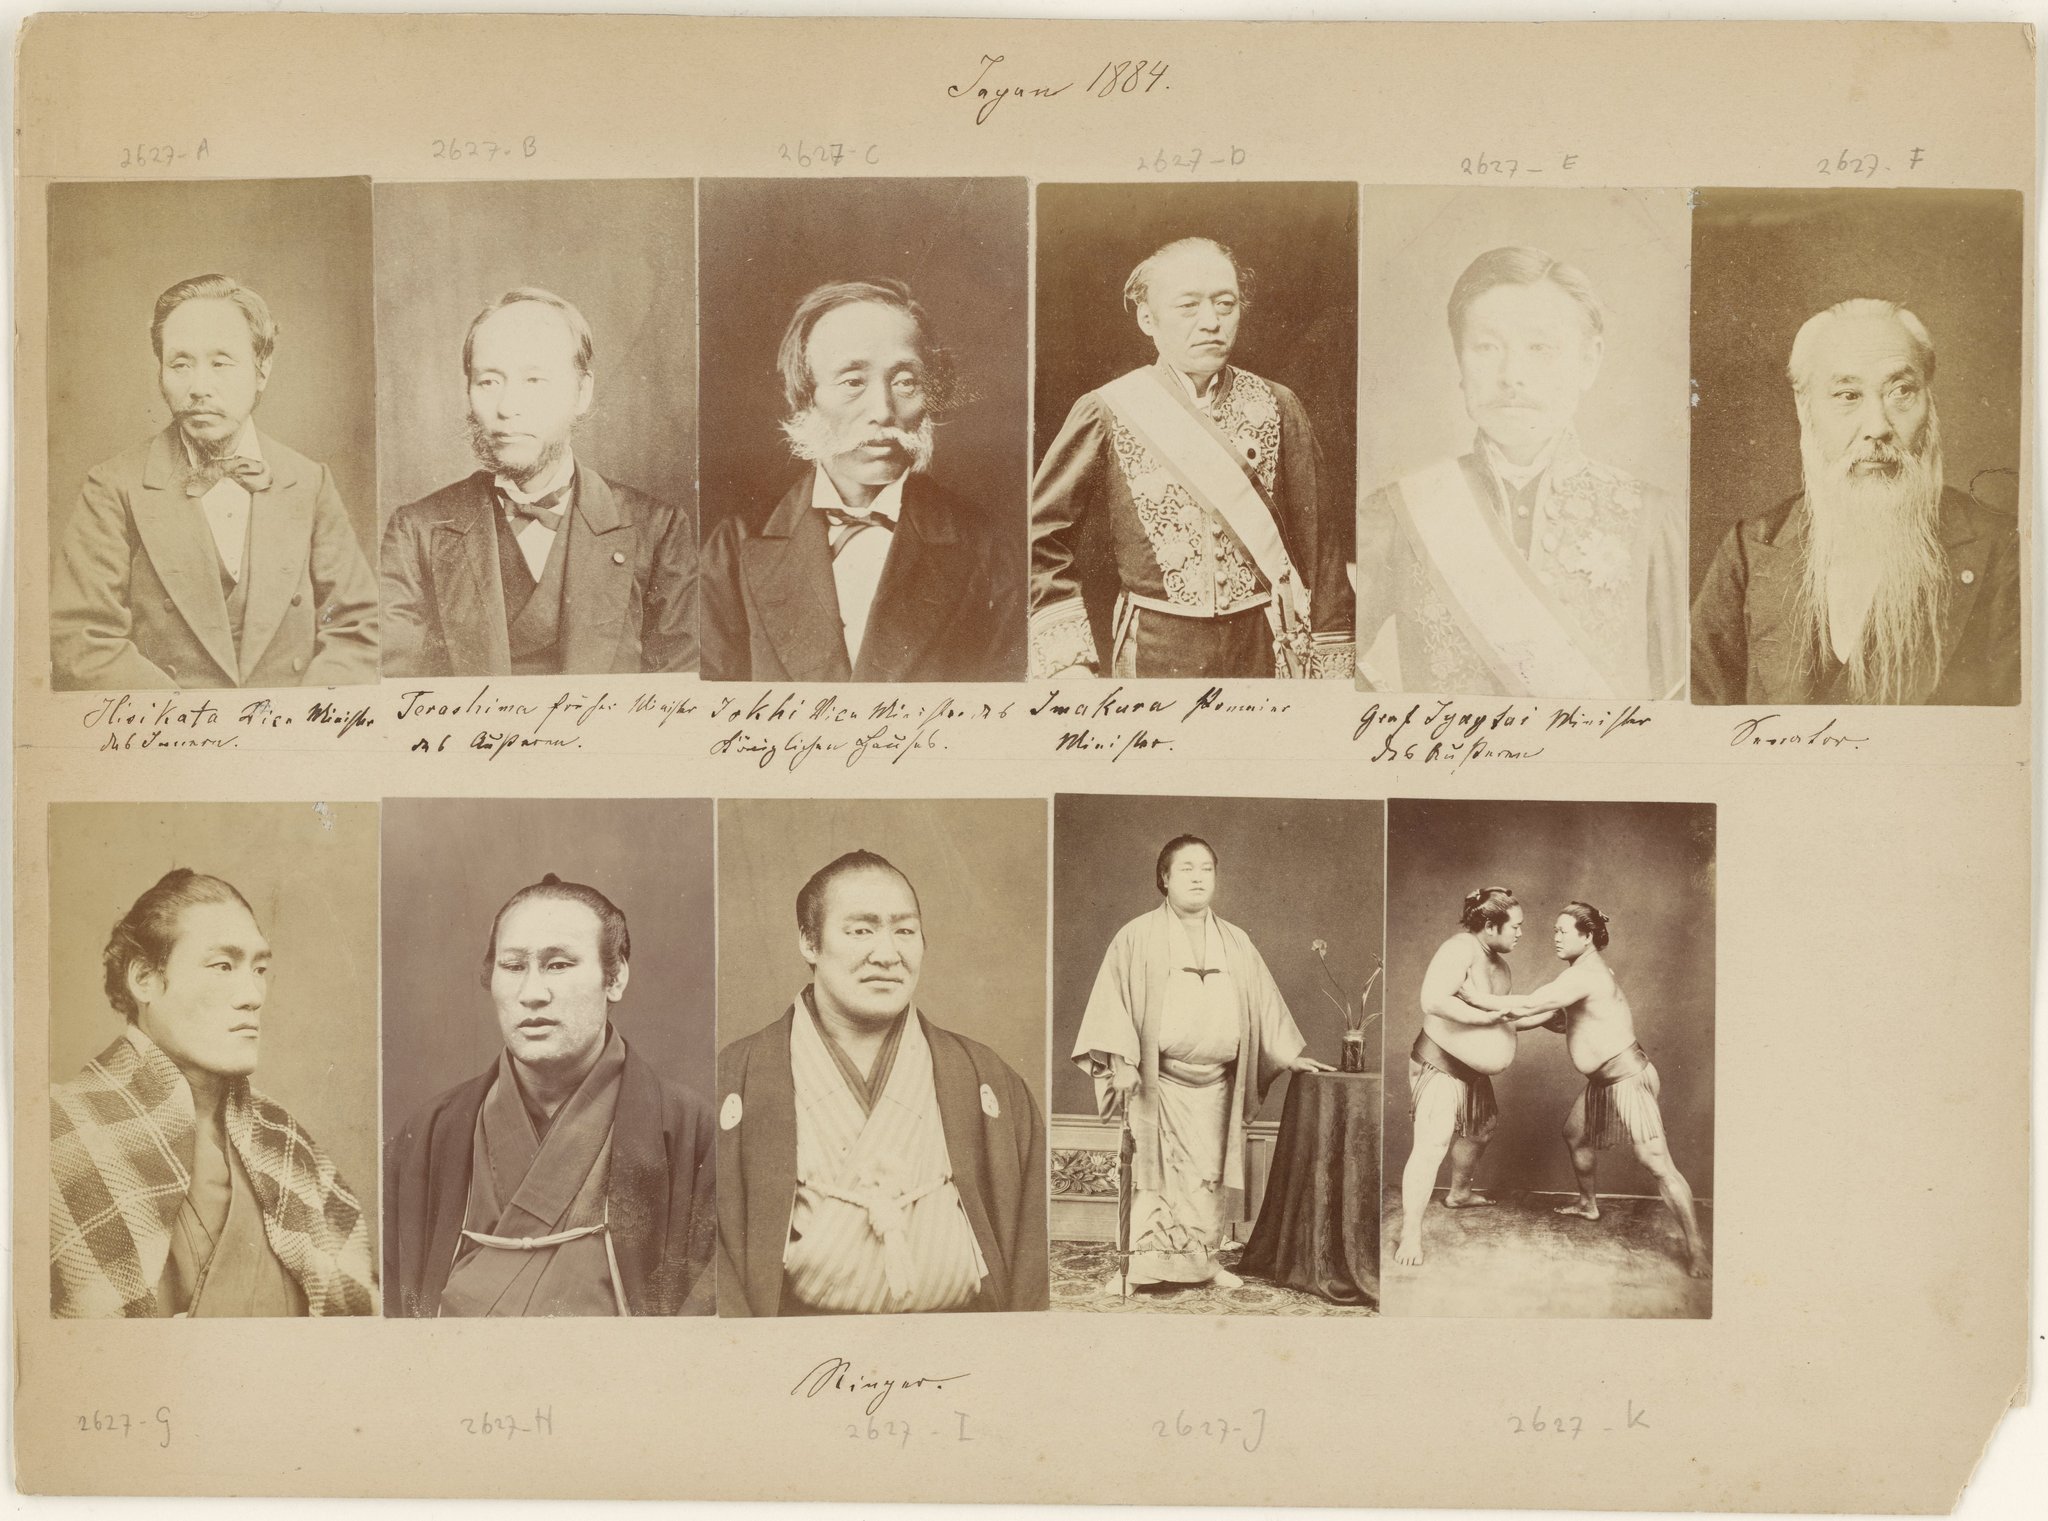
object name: photograph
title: Graf Iyuytai [?] Minister [...]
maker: Anonymous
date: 1884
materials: cardboard, paper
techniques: albumen print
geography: japan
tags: politician, minister ~ government, historical persons, japan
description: Onderdeel van een blad met elf portretten van Japanse mannen.